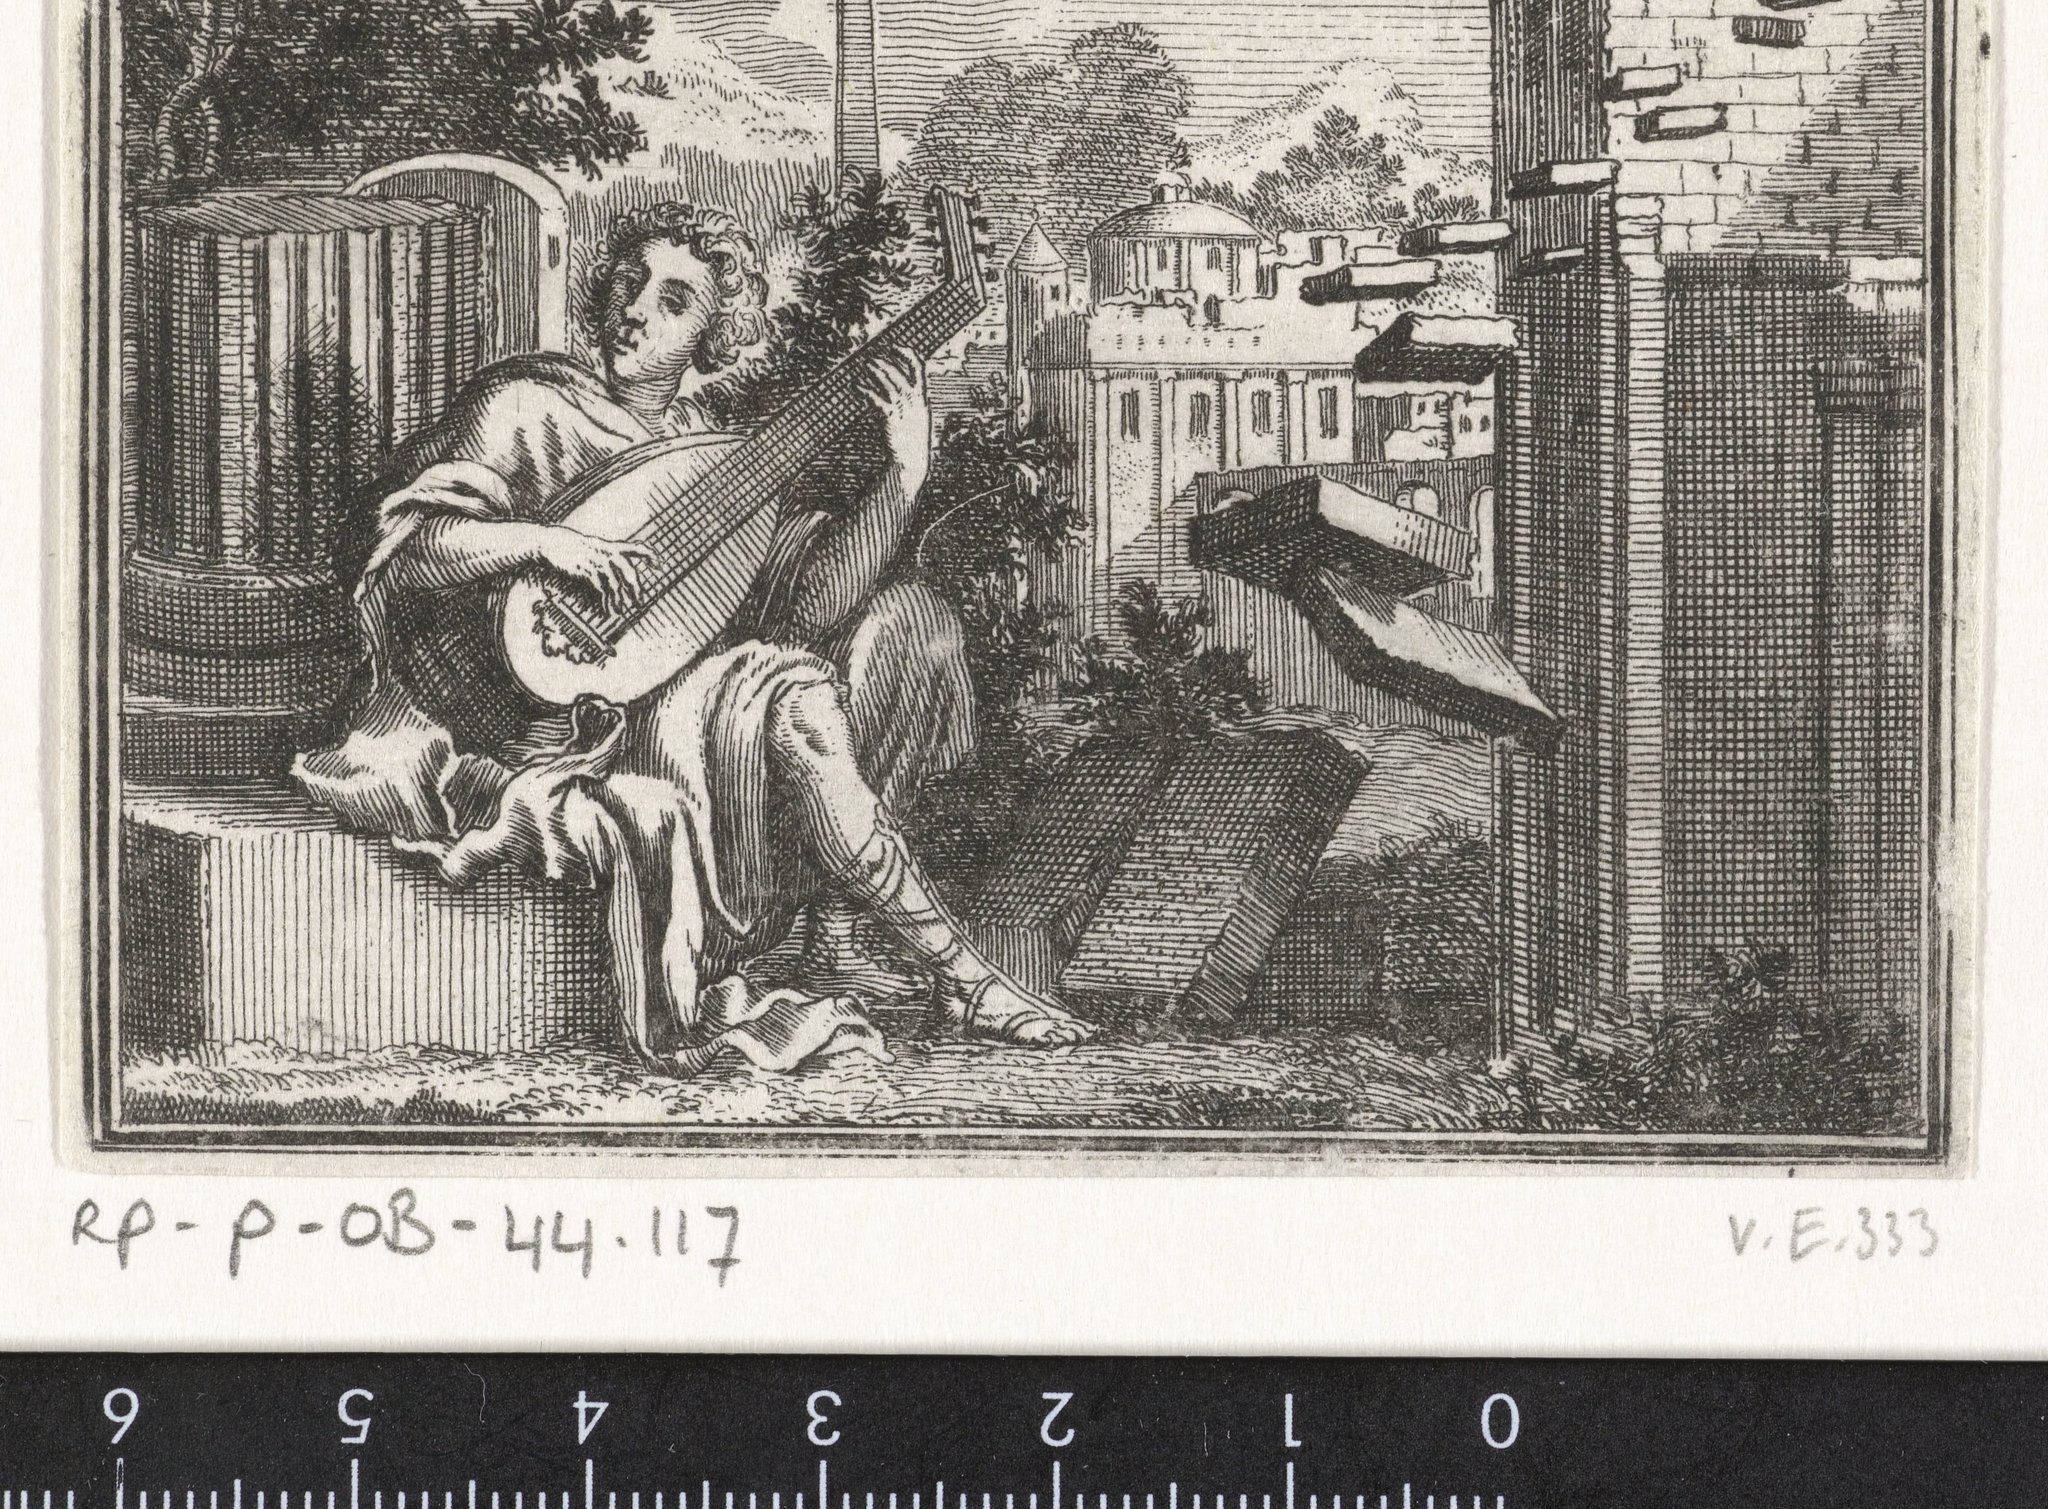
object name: print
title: Amphion, spelend op een luit bij de muren van Thebe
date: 1681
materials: paper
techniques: etching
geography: amsterdam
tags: (story of) amphion and zethus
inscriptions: collector's mark: Lugt 2228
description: Illustratie opgenomen in: Goeree, Wilhelmus. D'algemeene bouwkunde, volgens d'antyke en hedendaagse manier. Amsterdam: Willem Goeree, 1681. Kopie van dezelfde zijde naar prent van François Chauveau, opgenomen in: Metamorphoses d'Ovide en rondeaux par M. de Benserade. Parijs, 1676.